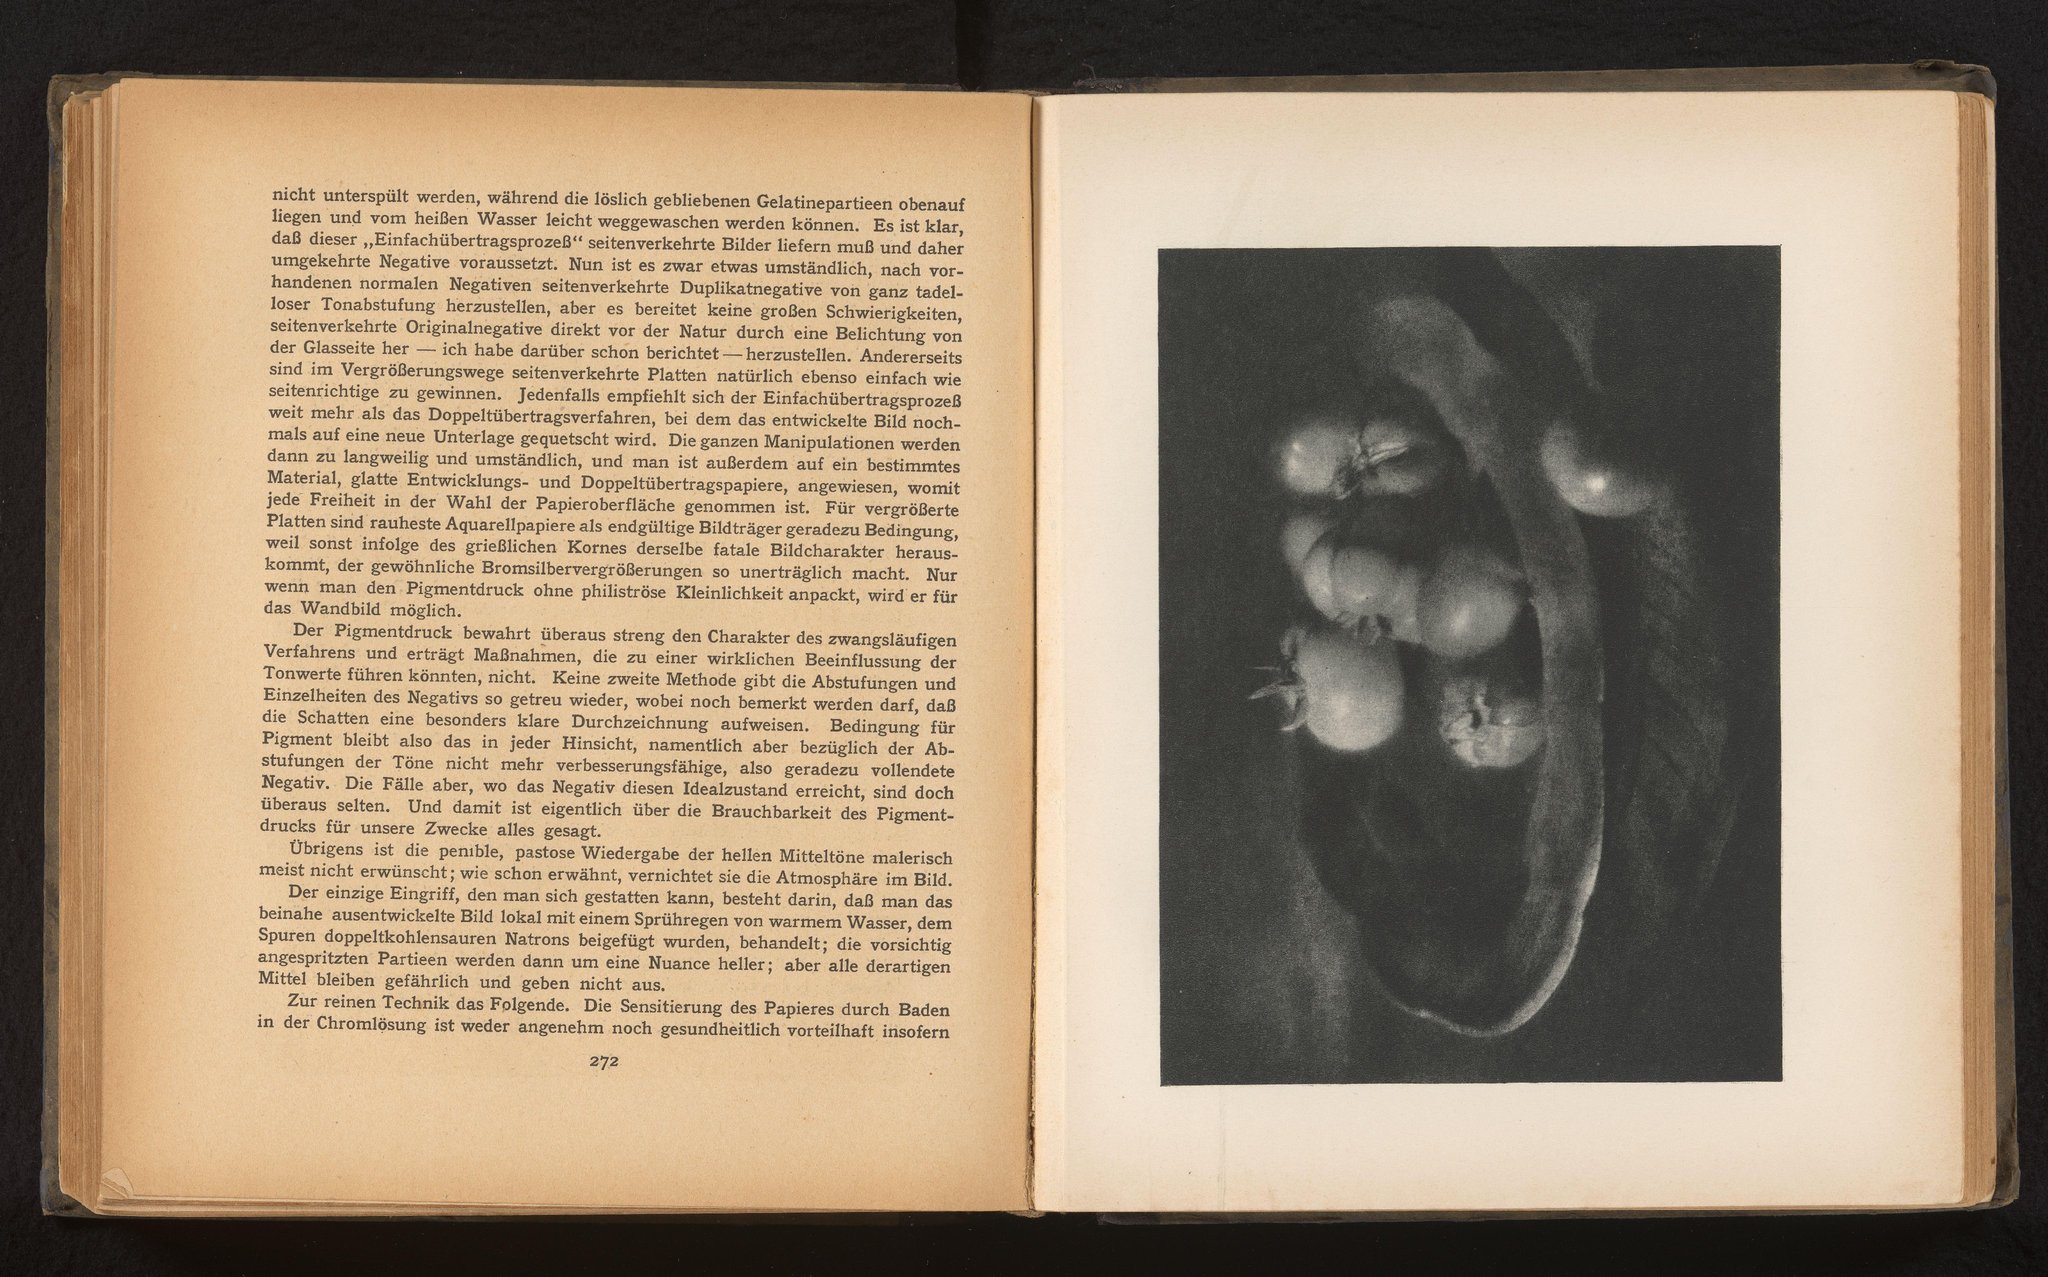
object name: photomechanical print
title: Fruitschaal met tomaten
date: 1916-1921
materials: paper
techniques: rotogravure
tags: foodstuffs; still life of foodstuffs